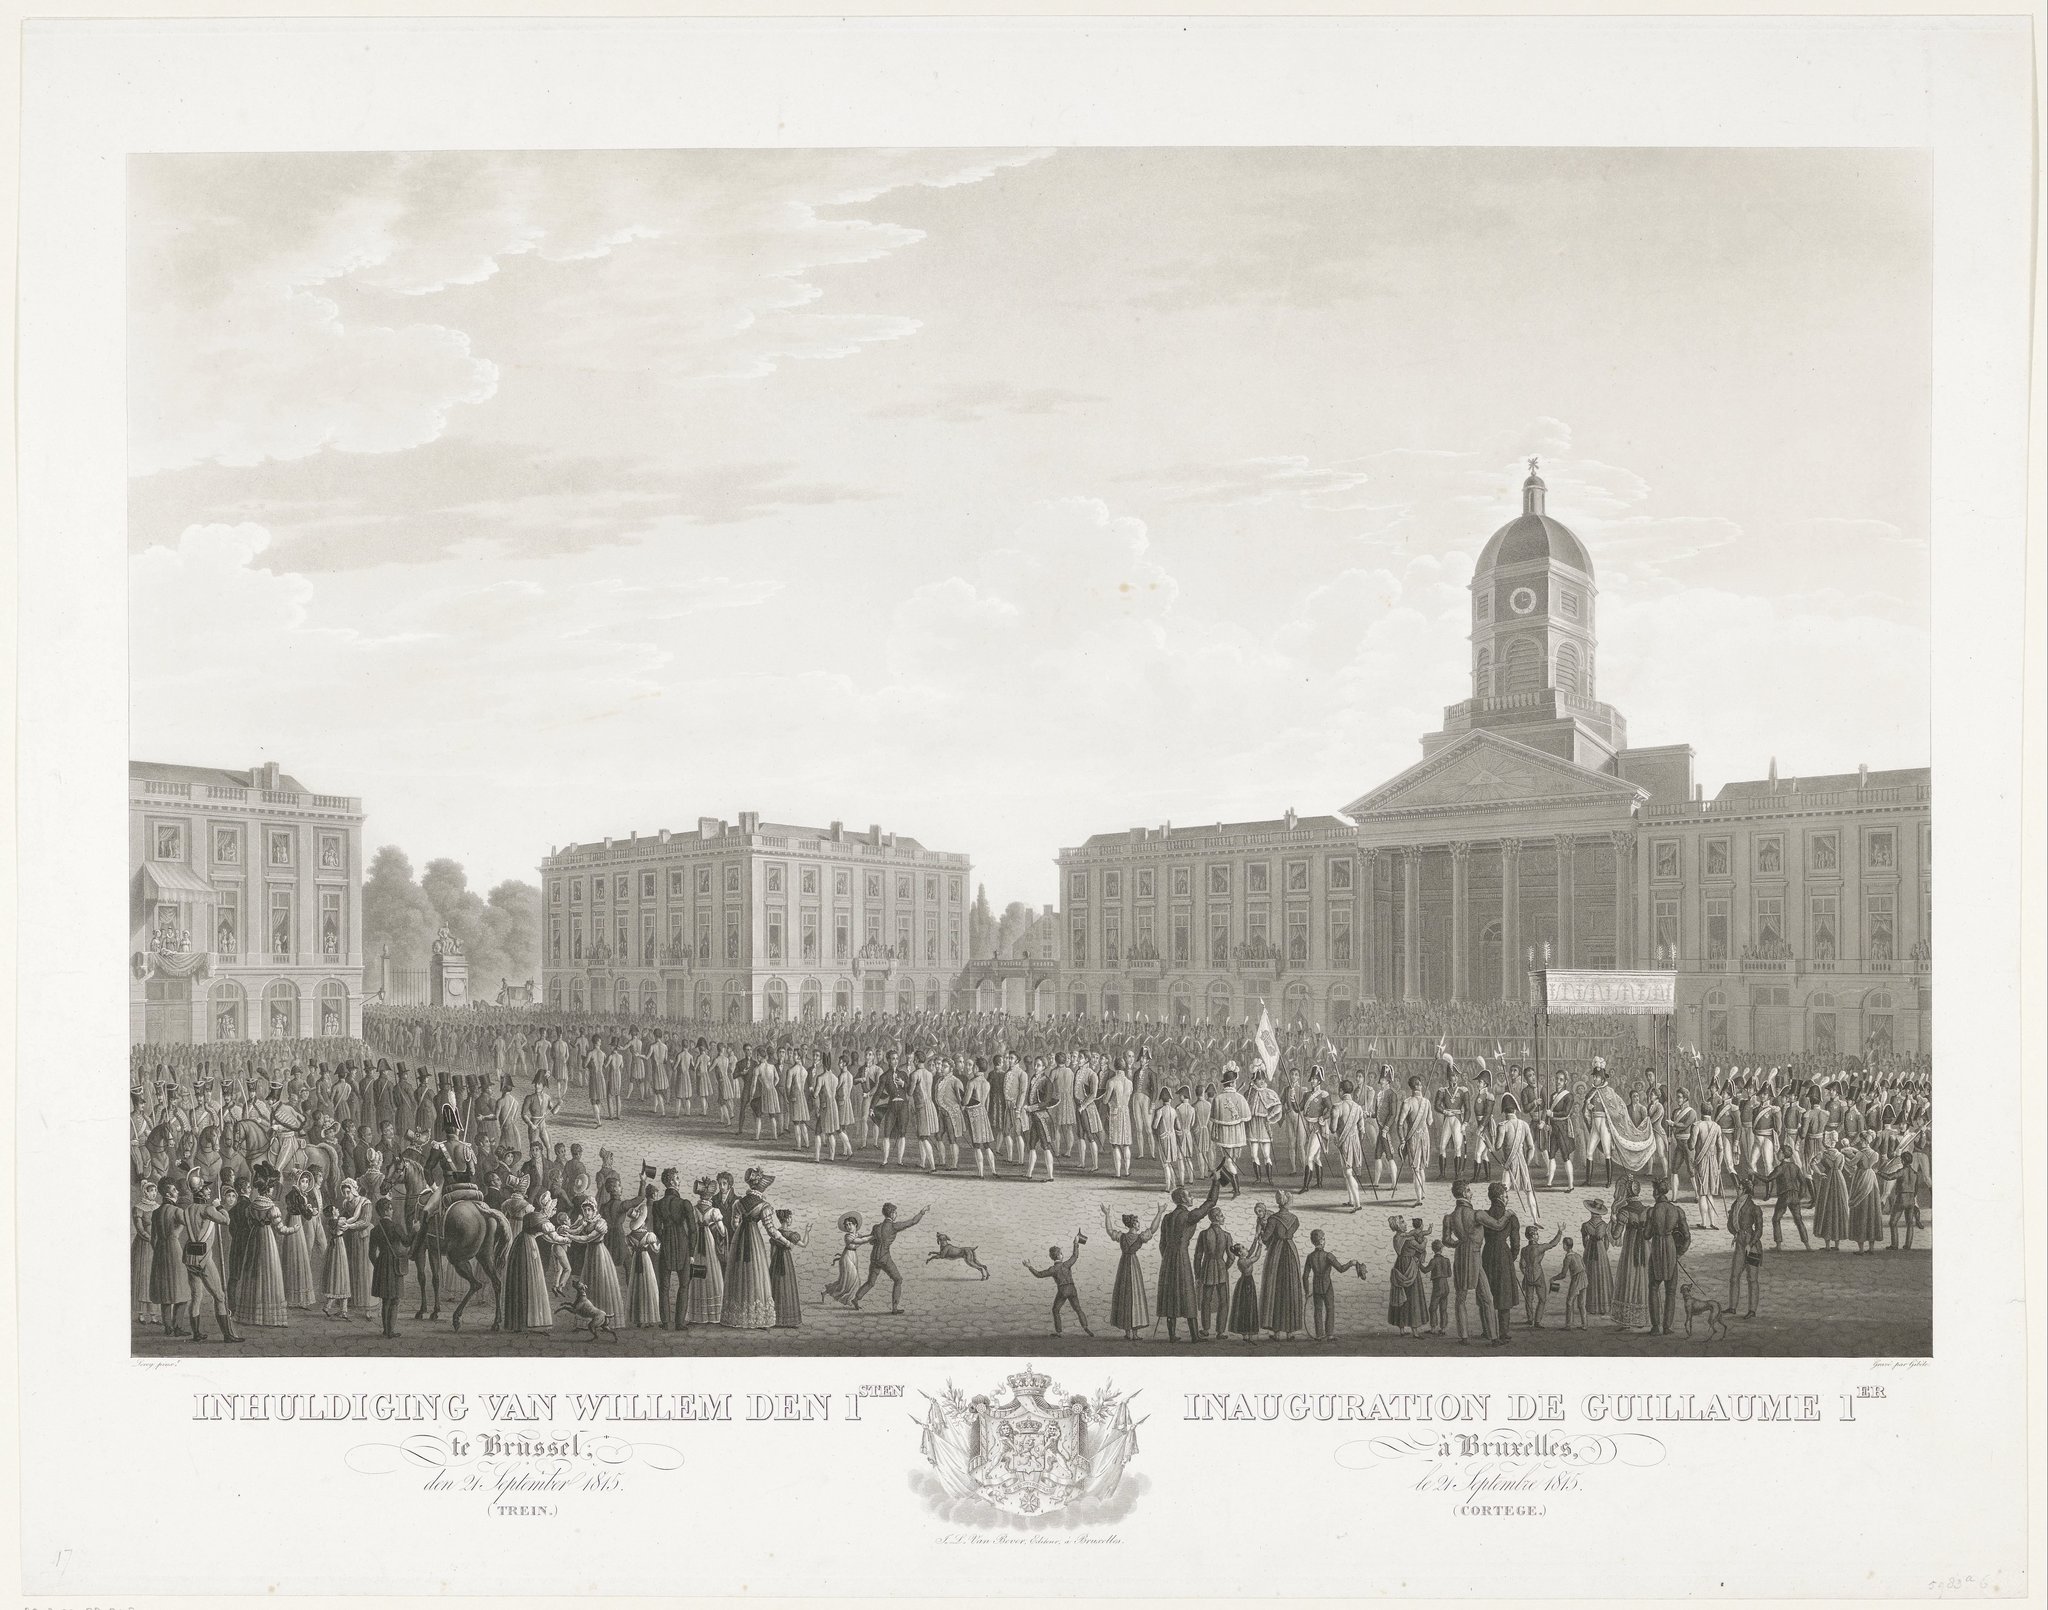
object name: print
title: Twaalf platen van de aankomst en inhuldiging van Willem I in Brussel en de slagen bij Quatre-Bras en Waterloo in 1815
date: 1825-1826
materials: paper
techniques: aquatint, etching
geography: brussels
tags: the hague, berlin, william i of the netherlands, ceremonial procession, parade, pageant ~ installation of a ruler, brussels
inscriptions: workshop stamp: ‘JLVB’, collector's mark: Lugt 2228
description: Optocht van koning Willem I na de inhuldiging op het Koningsplein bij de kerk Sint-Jacob-op-Koudenberg te Brussel op 21 september 1815. De koning lopend in de stoet onder een baldakijn. Onderaan de titels in het Nederlands en Frans gescheiden door het wapen van koning Willem I. Onderdeel van een serie platen van de aankomst en inhuldiging van Willem I in Brussel.